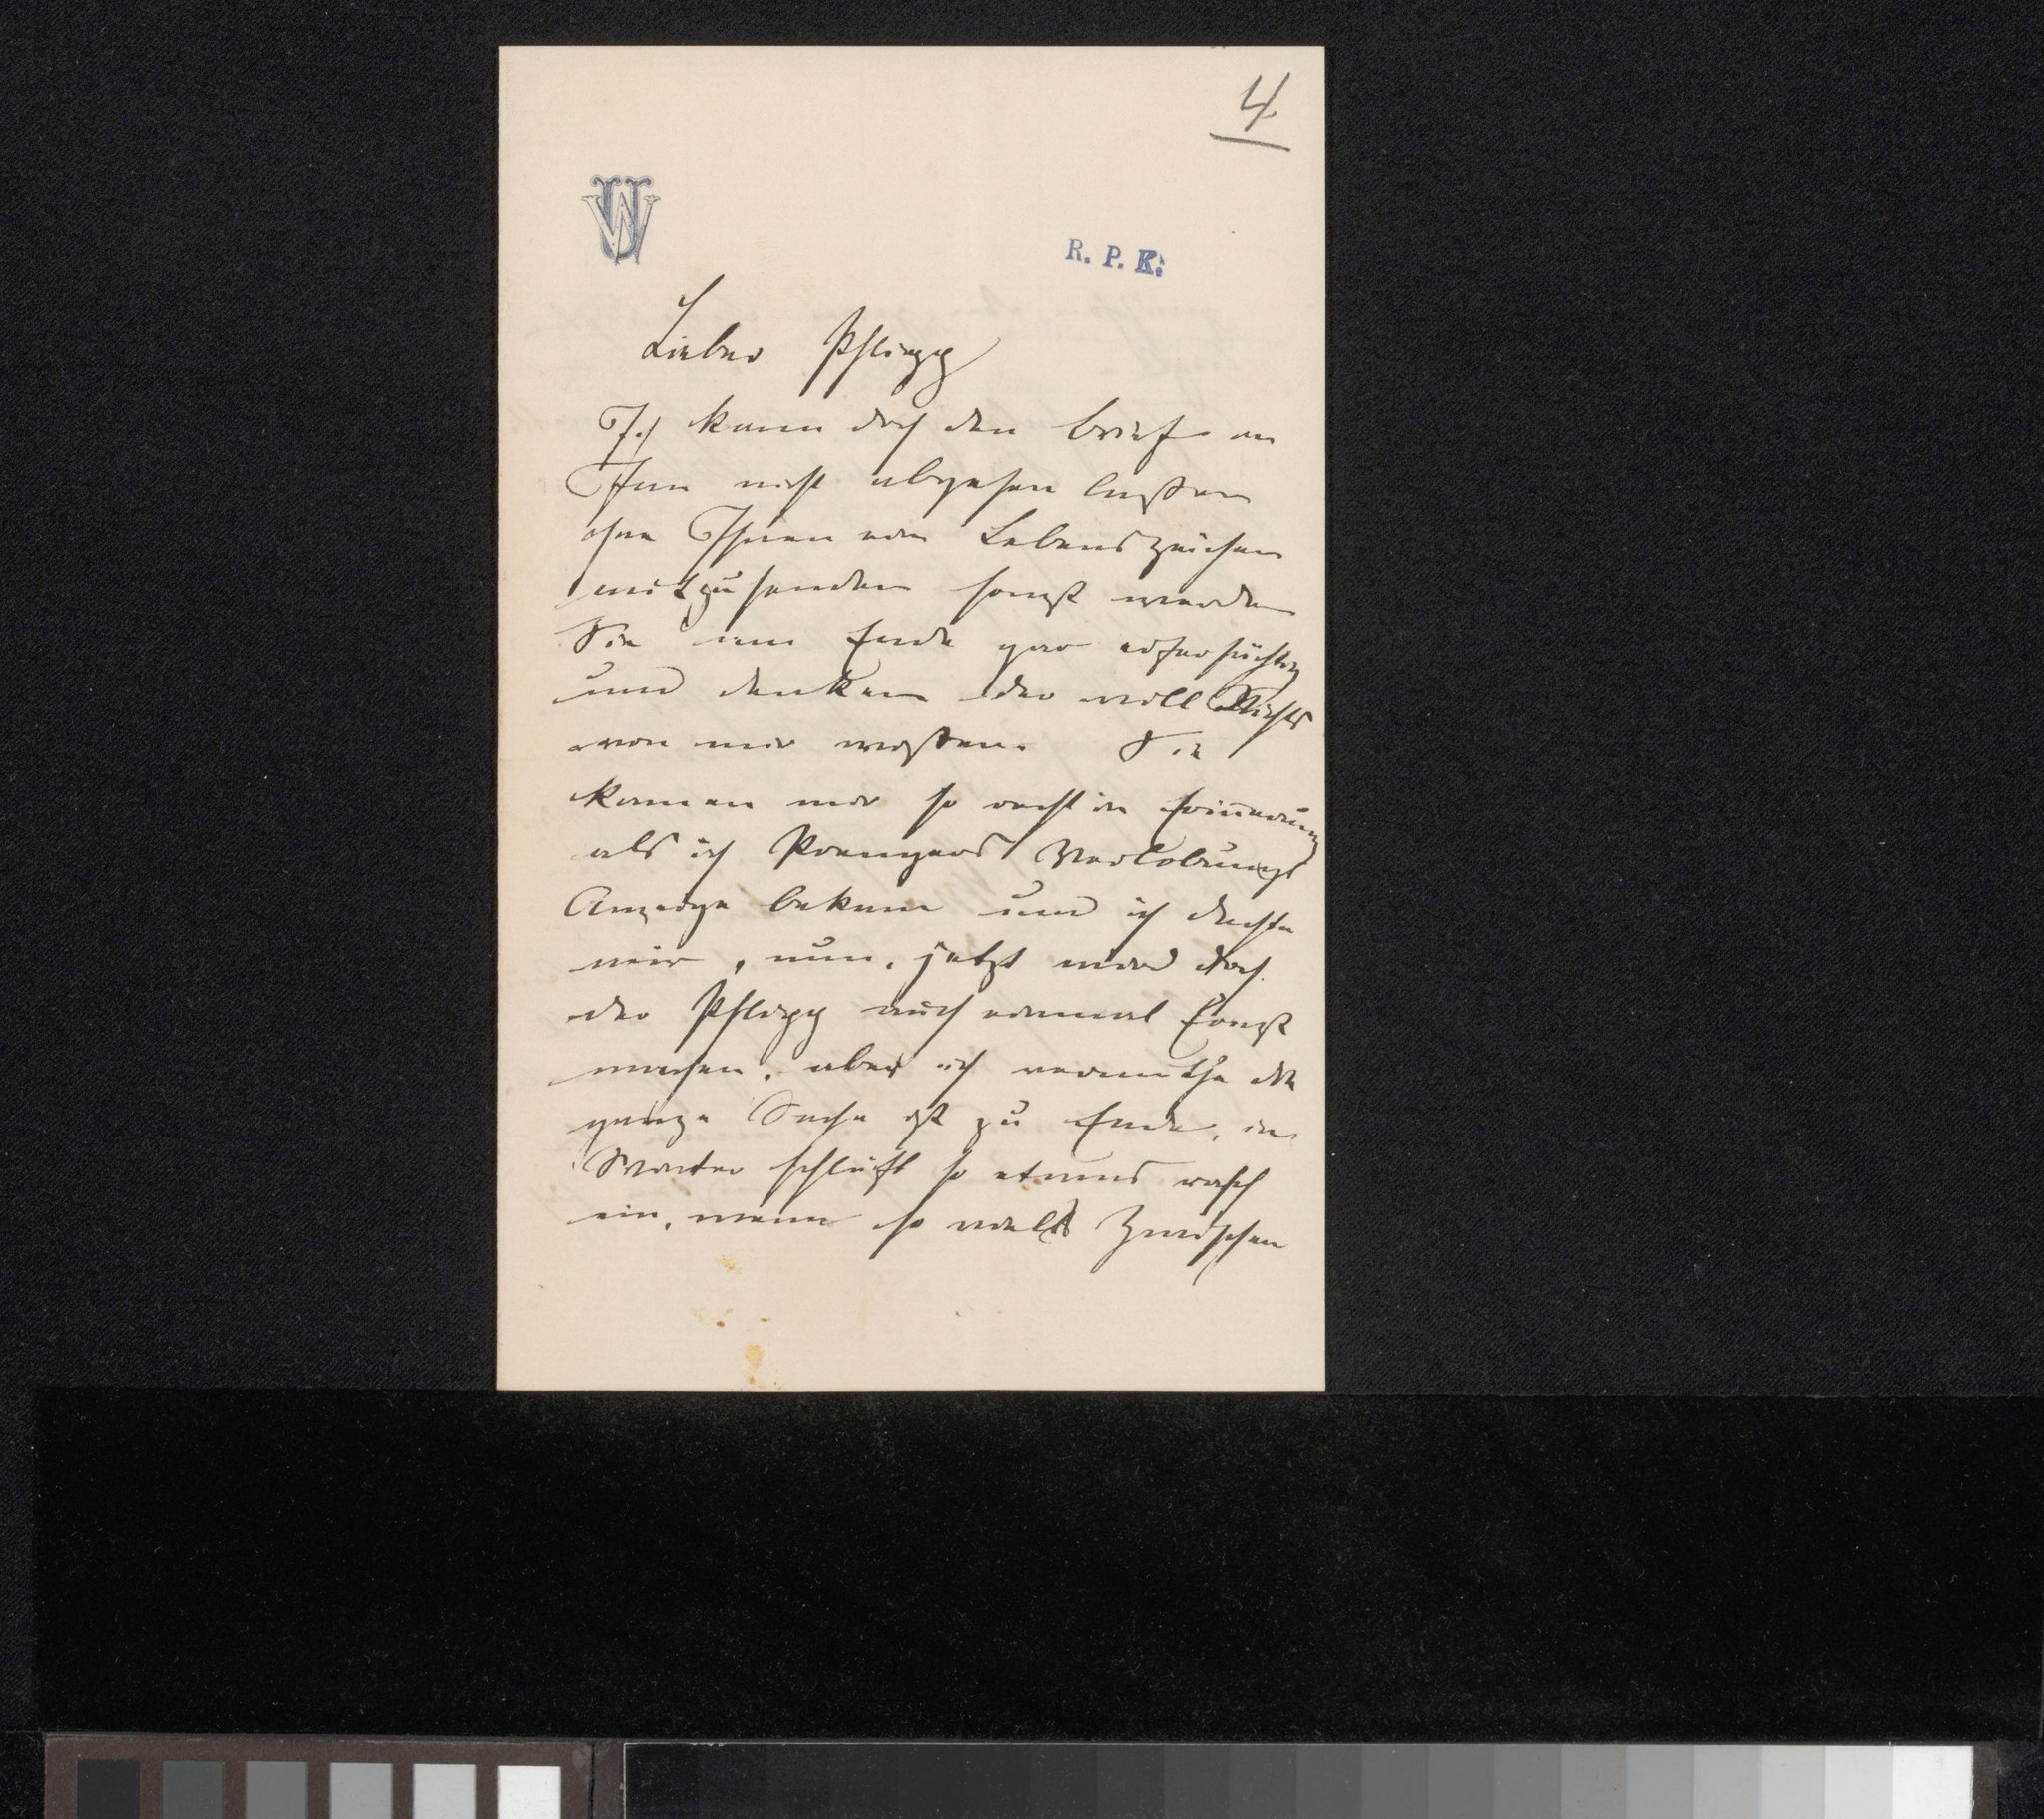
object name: letter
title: Brief aan onbekend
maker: william unger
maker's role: draughtsman, painter, print maker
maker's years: 1837-1932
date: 1847-1932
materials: ink, paper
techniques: pen, printing, writing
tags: publisher, art trade, art shop, art collecting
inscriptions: watermark, collector's mark: Lugt 2233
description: Brief gedateerd januari 1875 in latere hand.